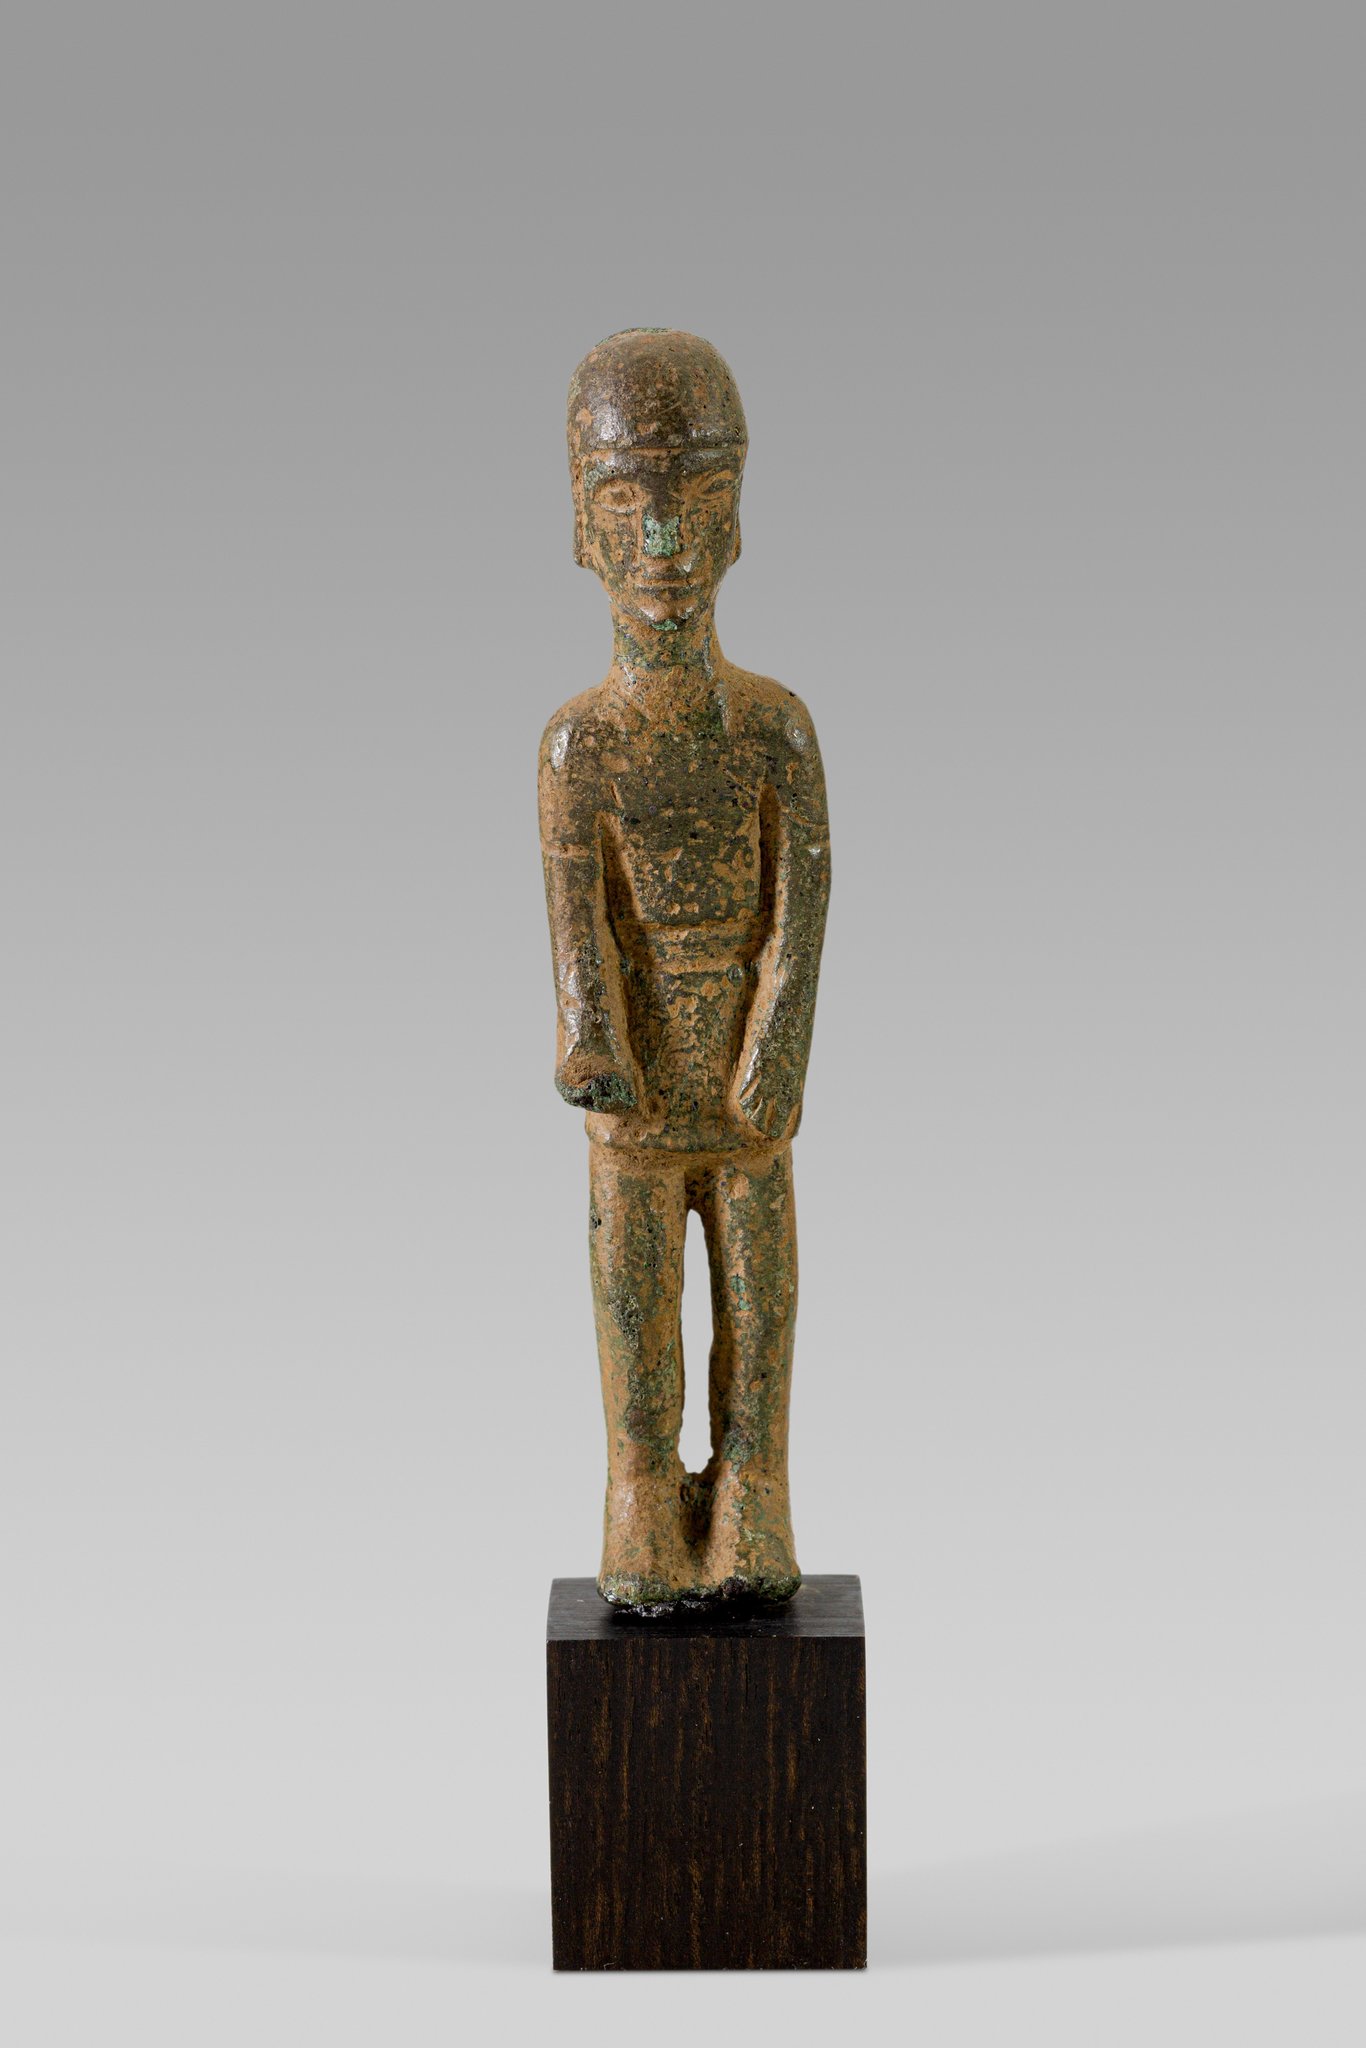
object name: statuette of a warrior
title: Bronze statuette of a warrior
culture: iberian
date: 500-401 BCE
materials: bronze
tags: warriors